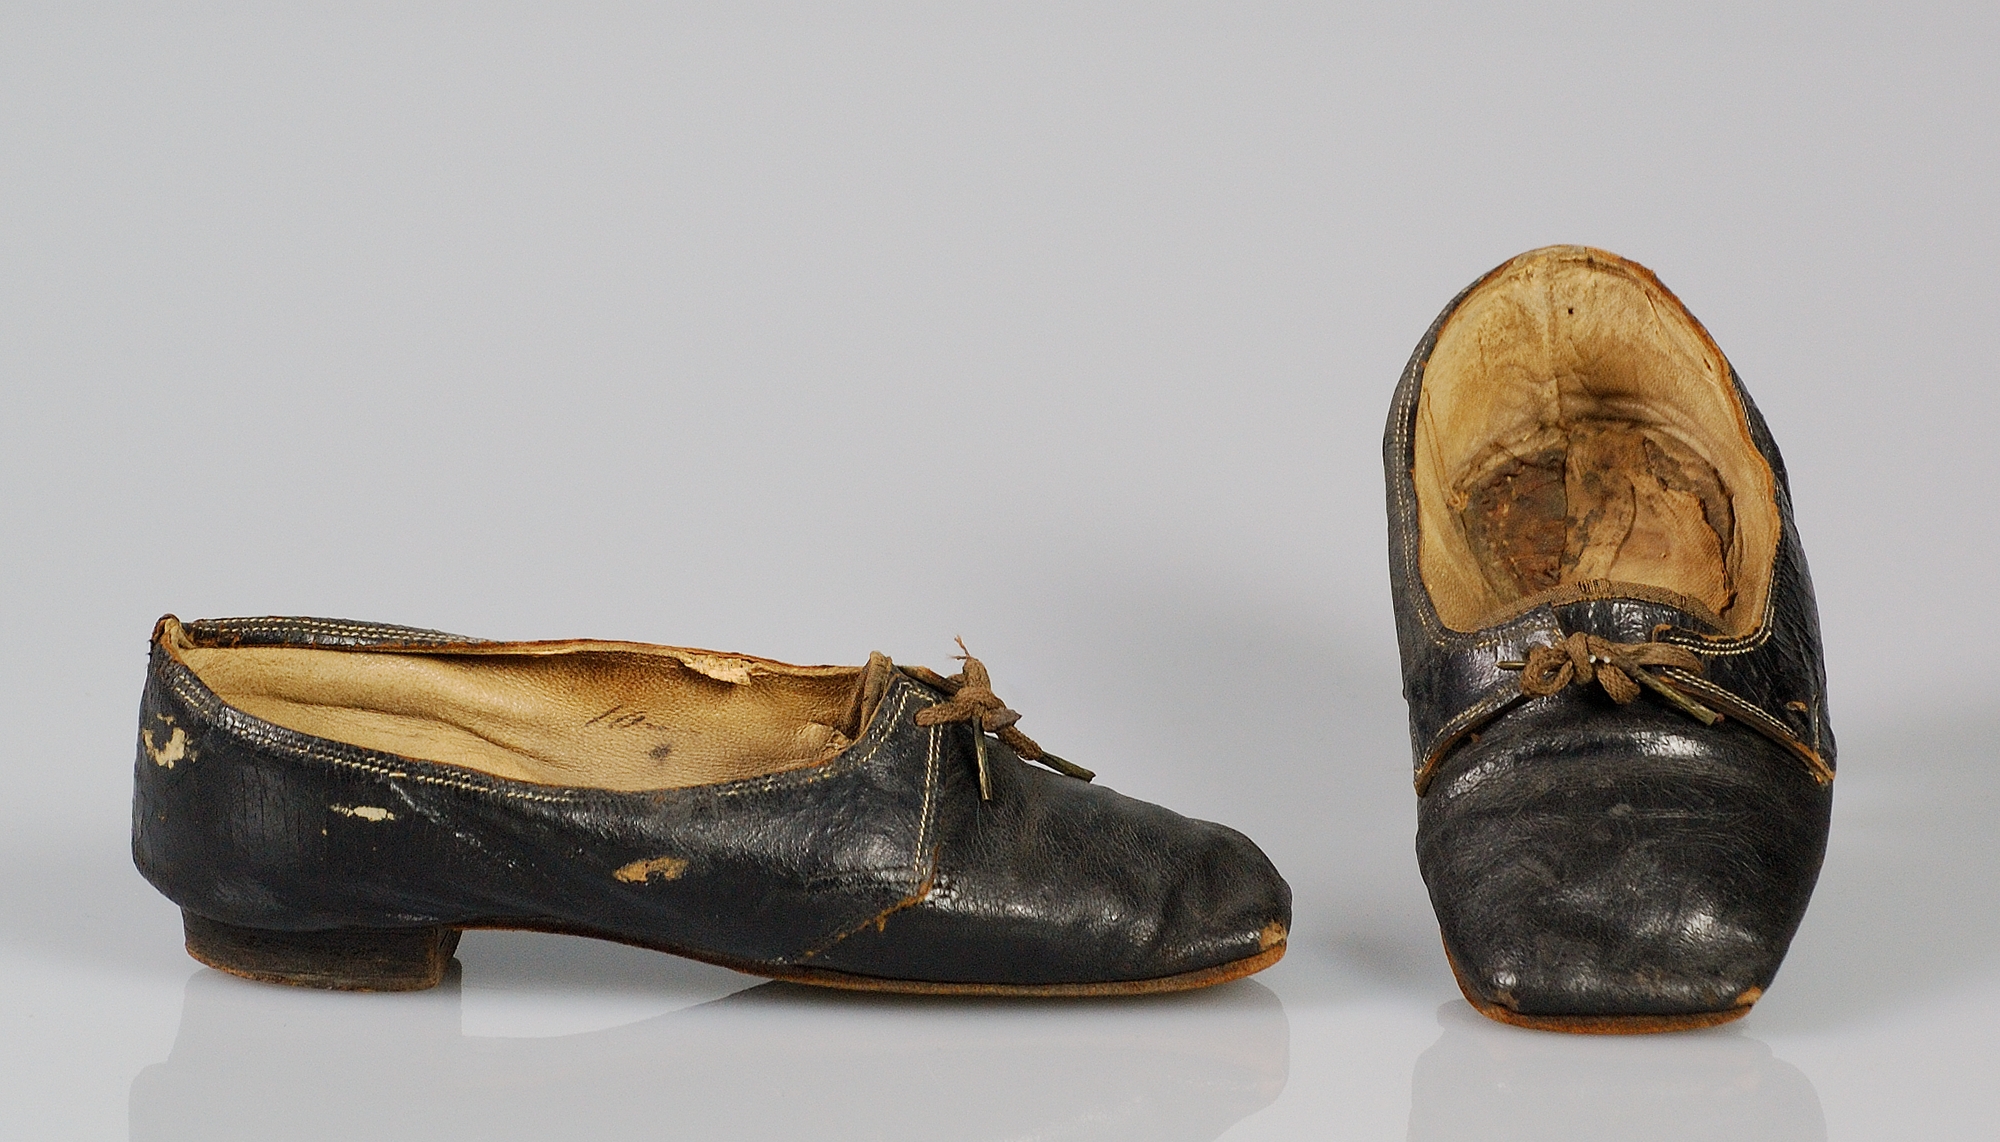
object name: shoe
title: Shoes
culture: american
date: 1840-1859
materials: leather